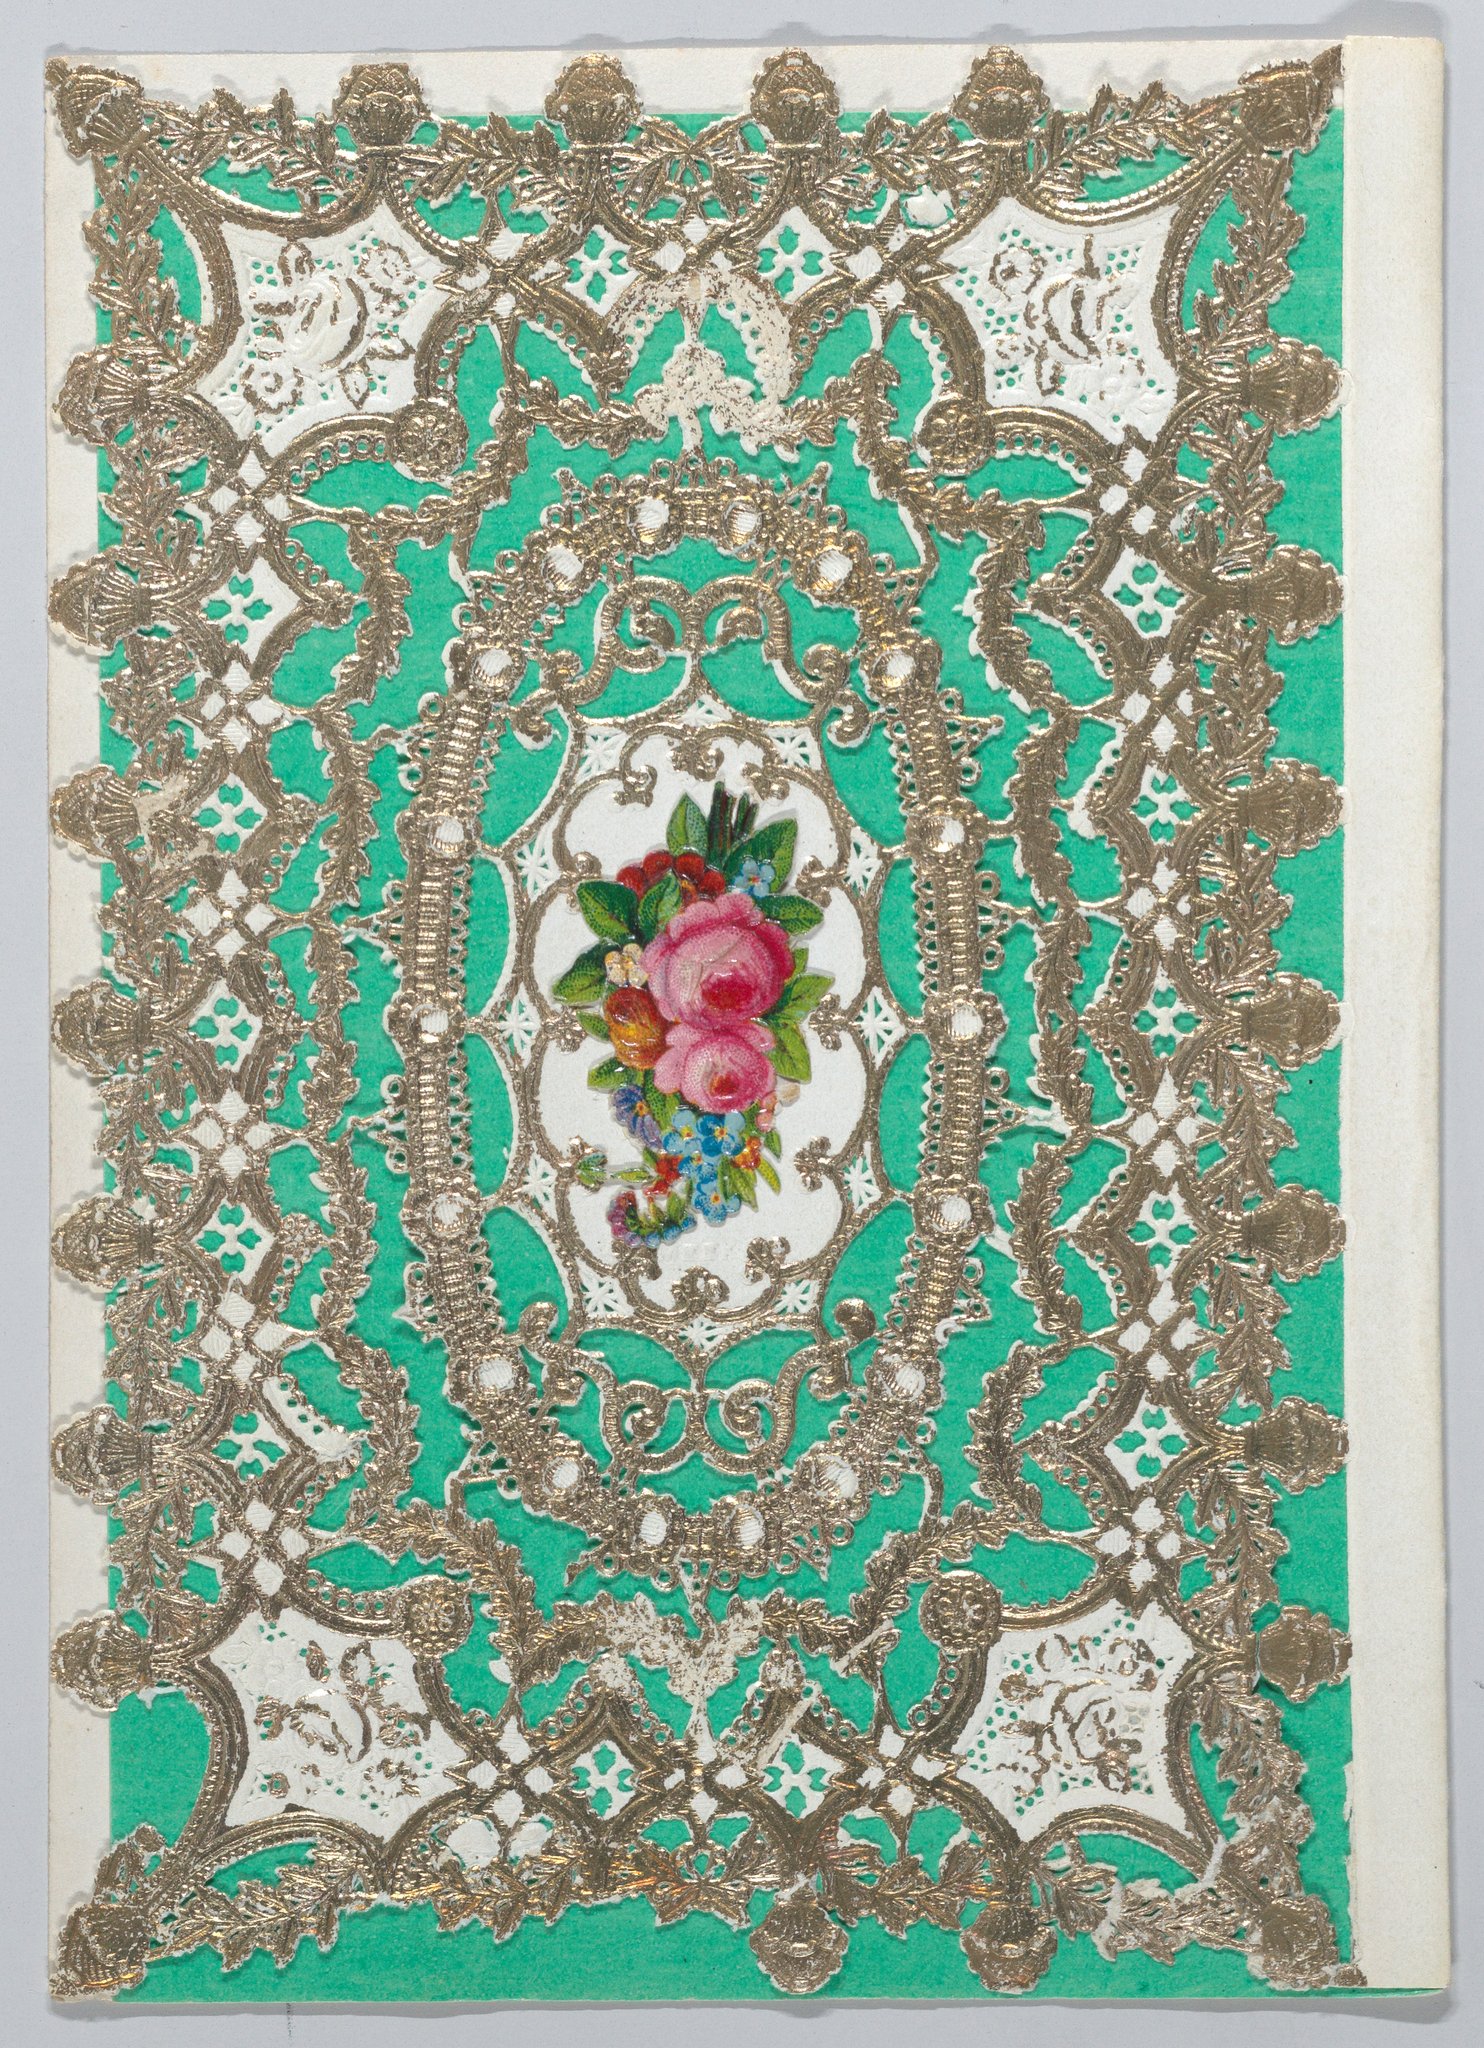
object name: valentine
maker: esther howland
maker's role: artist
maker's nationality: american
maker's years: 1828-1904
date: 1834-1866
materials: lace, paper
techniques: cutting